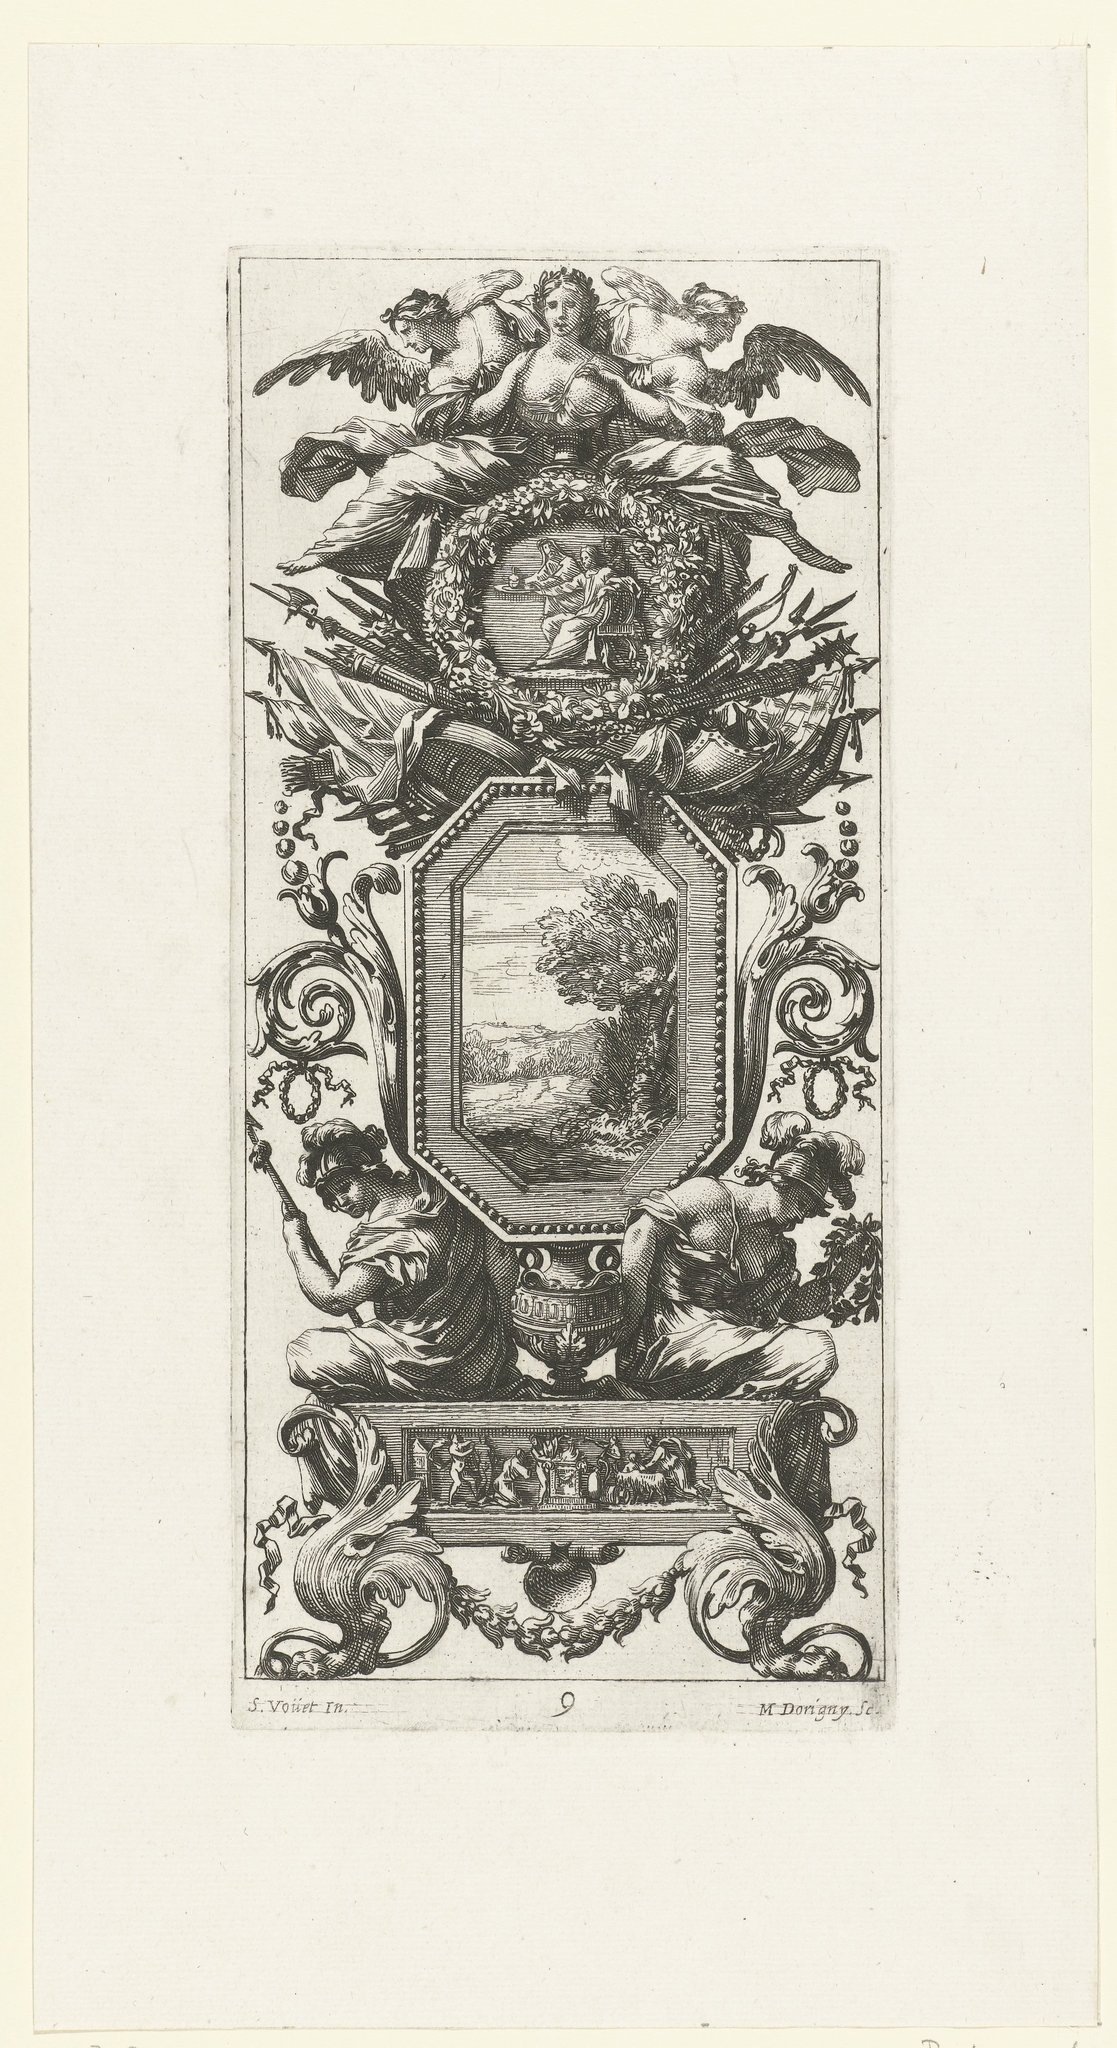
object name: print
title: Livre De Diverses Grotesques, Peintes Dans Le Cabinet De La Reine Régente, Au Palais Royal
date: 1647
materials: paper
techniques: engraving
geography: paris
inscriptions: collector's mark: Lugt 240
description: Lijst met een landschap, steunend op een vaas.